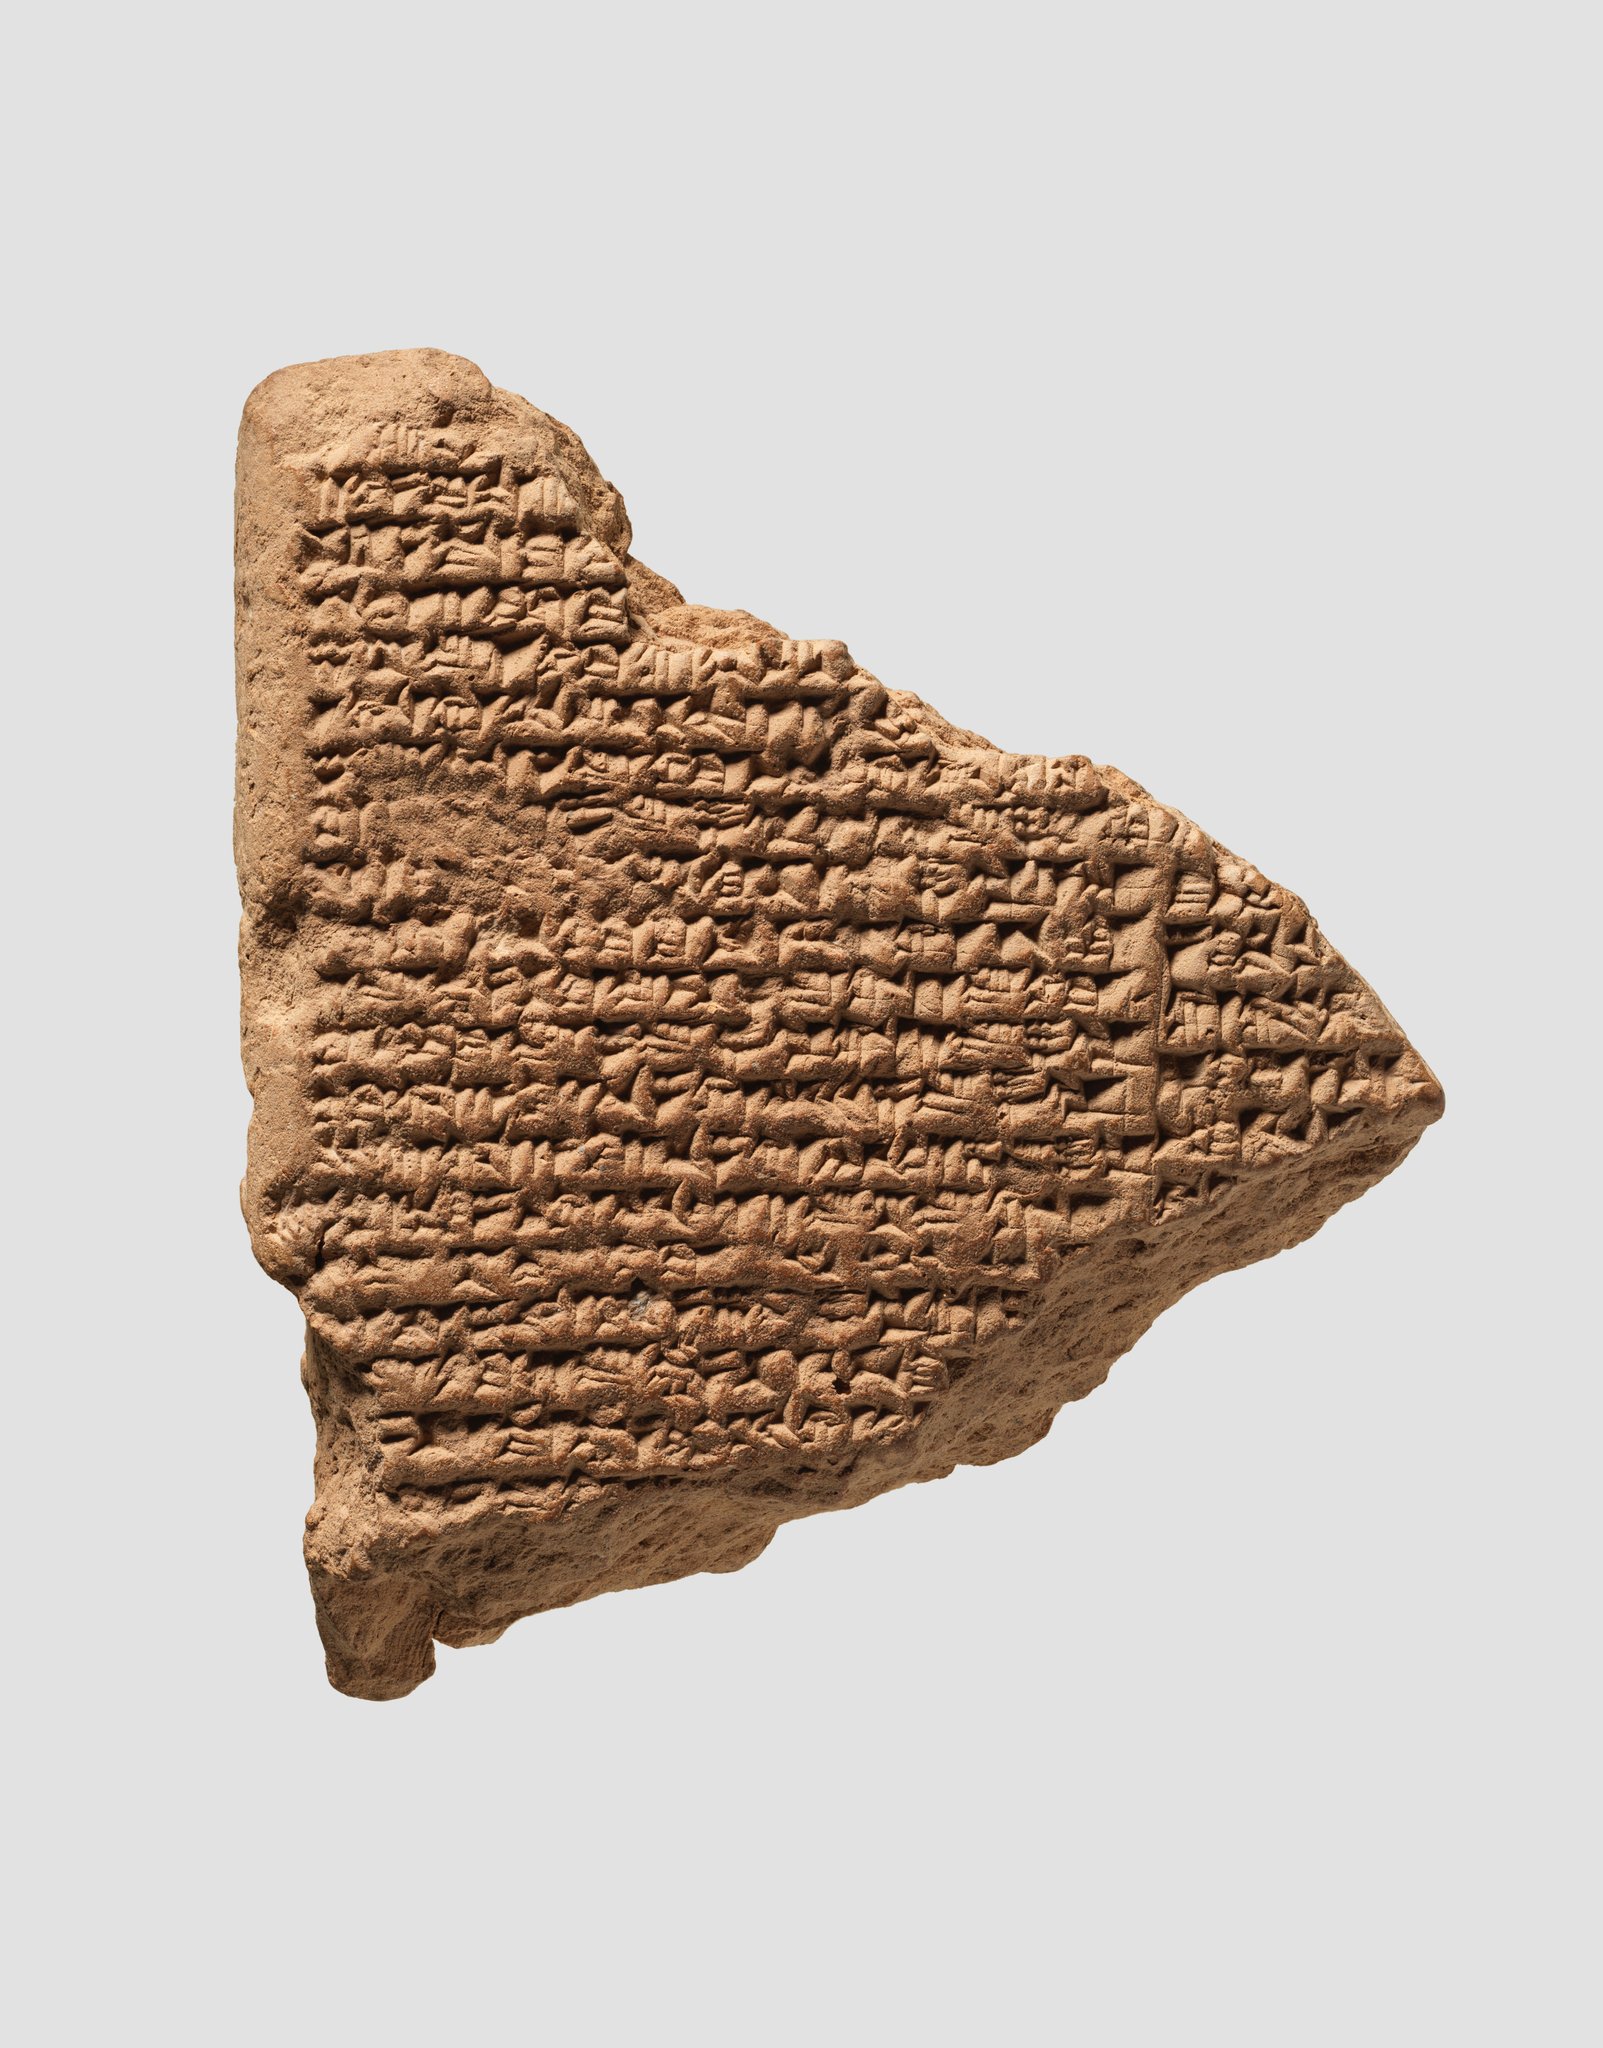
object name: cuneiform tablet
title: Cuneiform tablet: measurements of the interior of the E-sagil temple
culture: parthian or seleucid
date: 367-400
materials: clay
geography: mesopotamia